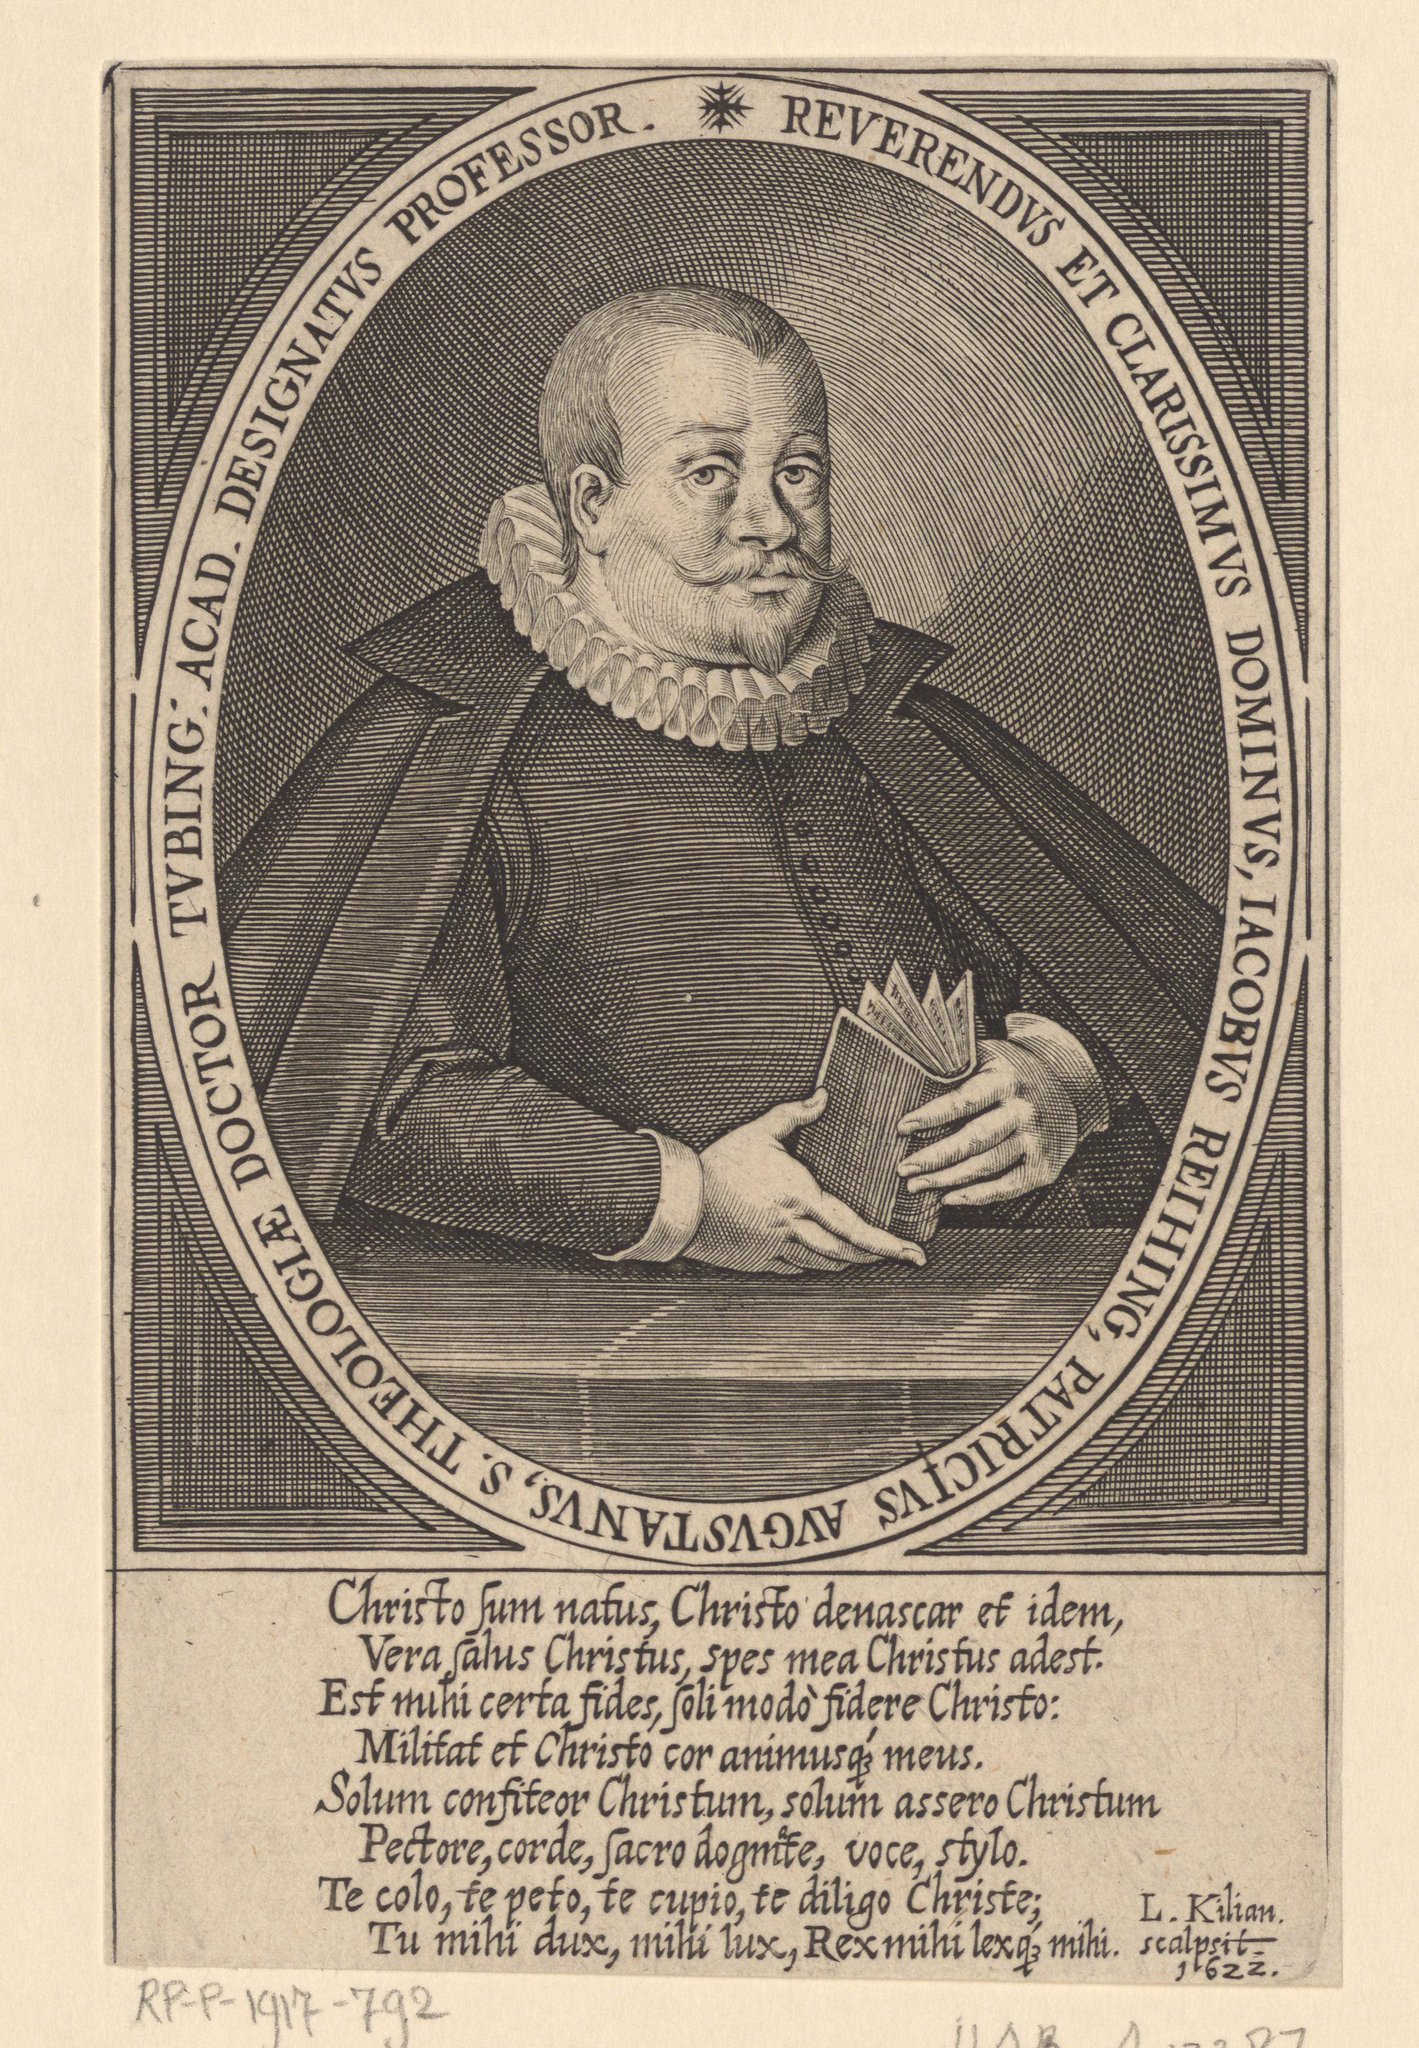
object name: print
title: Portret van Jacob Reihing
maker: lucas kilian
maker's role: draughtsman, print maker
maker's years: 1579-1637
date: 1622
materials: paper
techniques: engraving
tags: historical persons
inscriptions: collector's mark: Lugt 2228